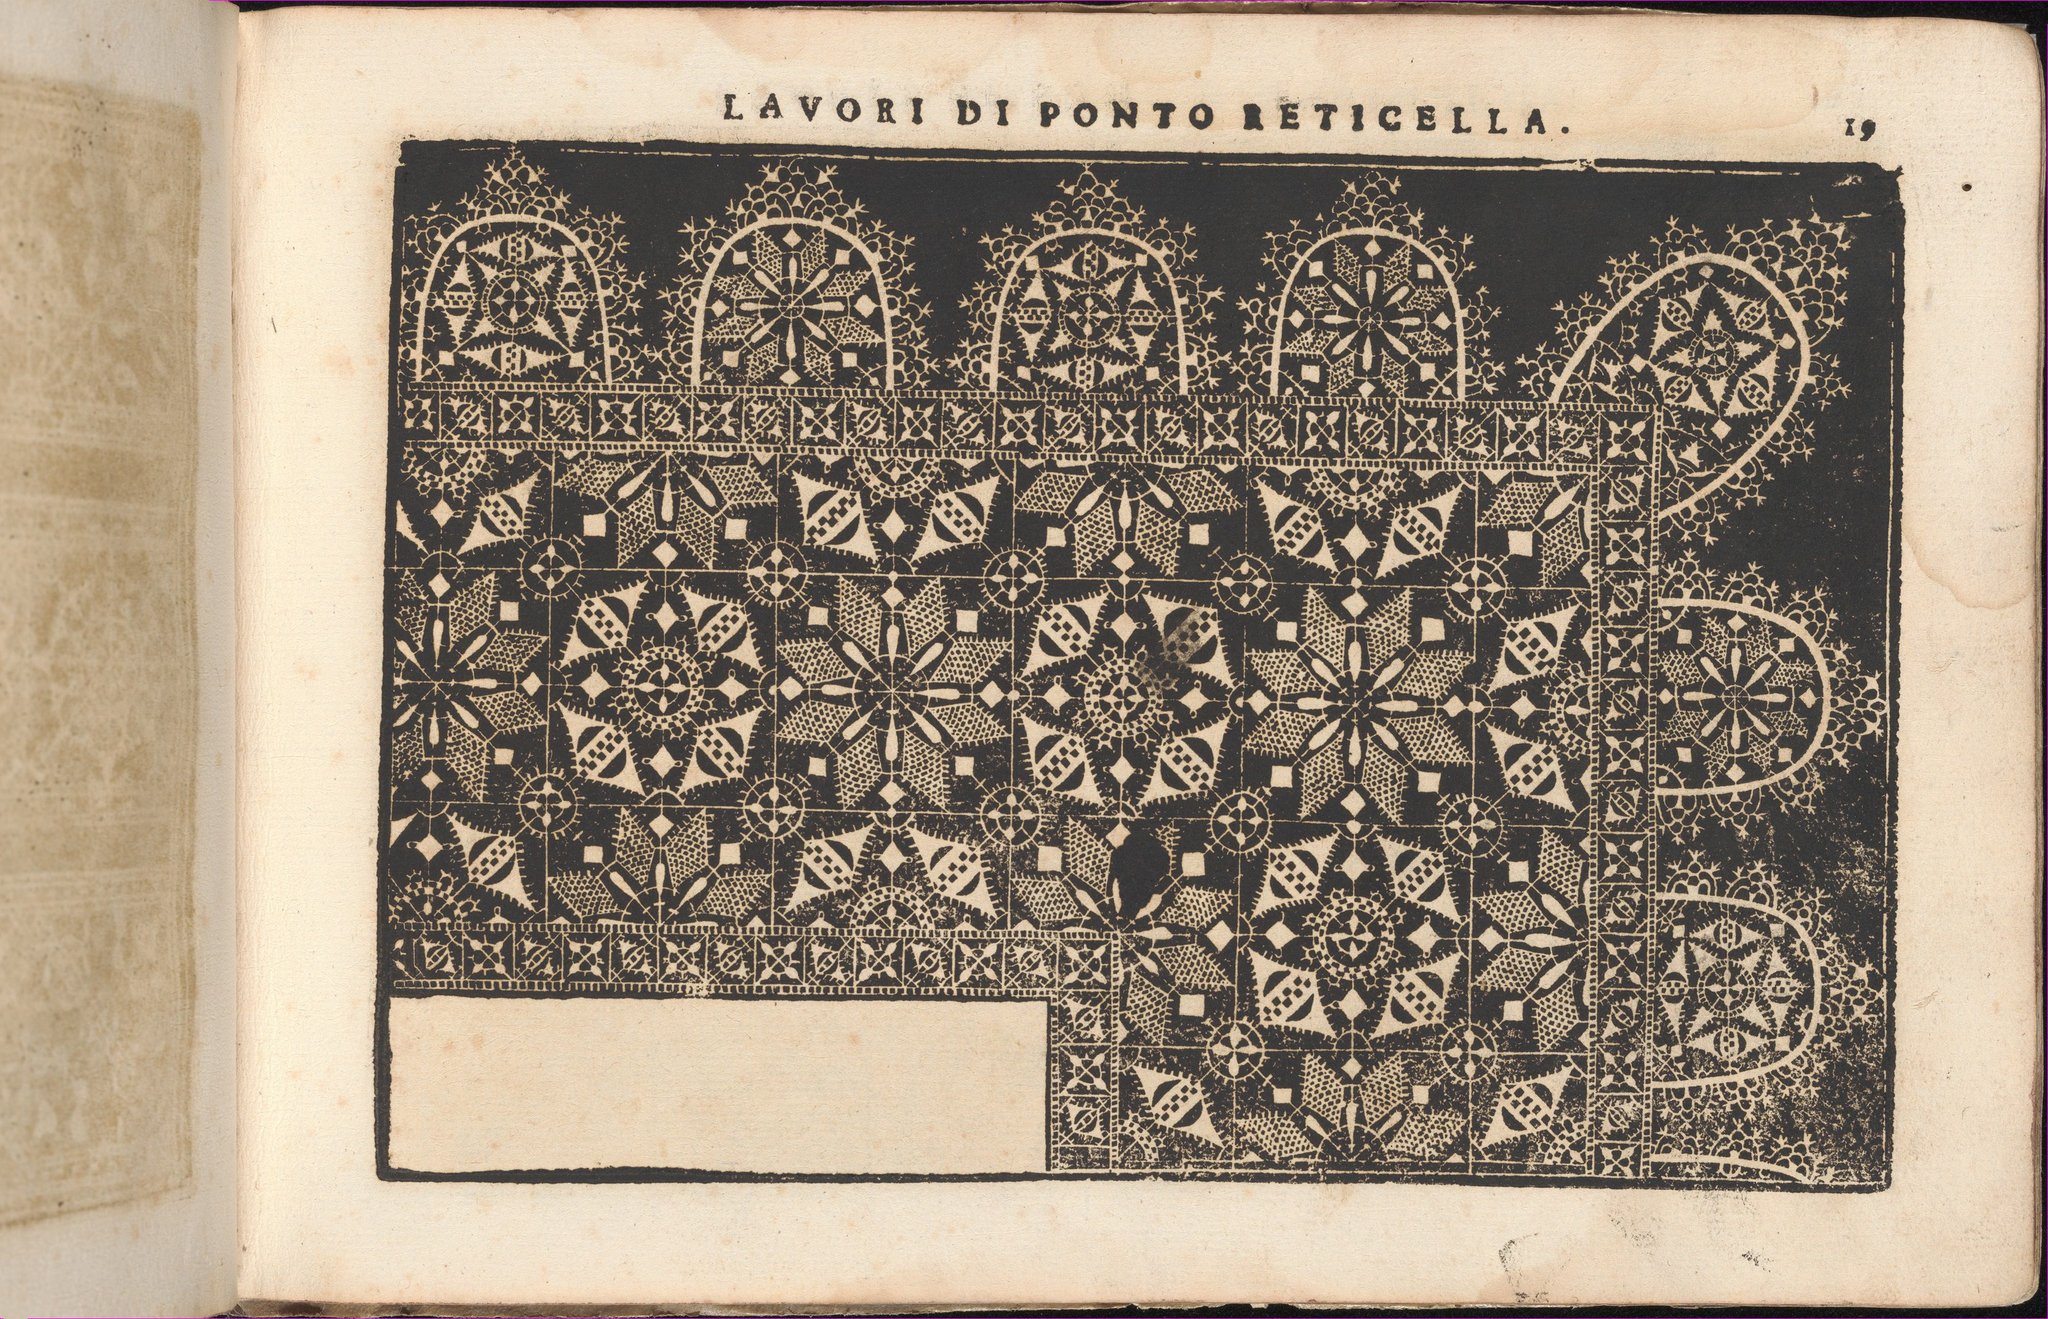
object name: book print ornament architecture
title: Teatro delle Nobili et Virtuose Donne..., page 21 (recto)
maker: isabella catanea parasole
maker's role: author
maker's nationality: italian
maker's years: 1565-1625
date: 1616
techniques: engraving, woodcut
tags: ornament